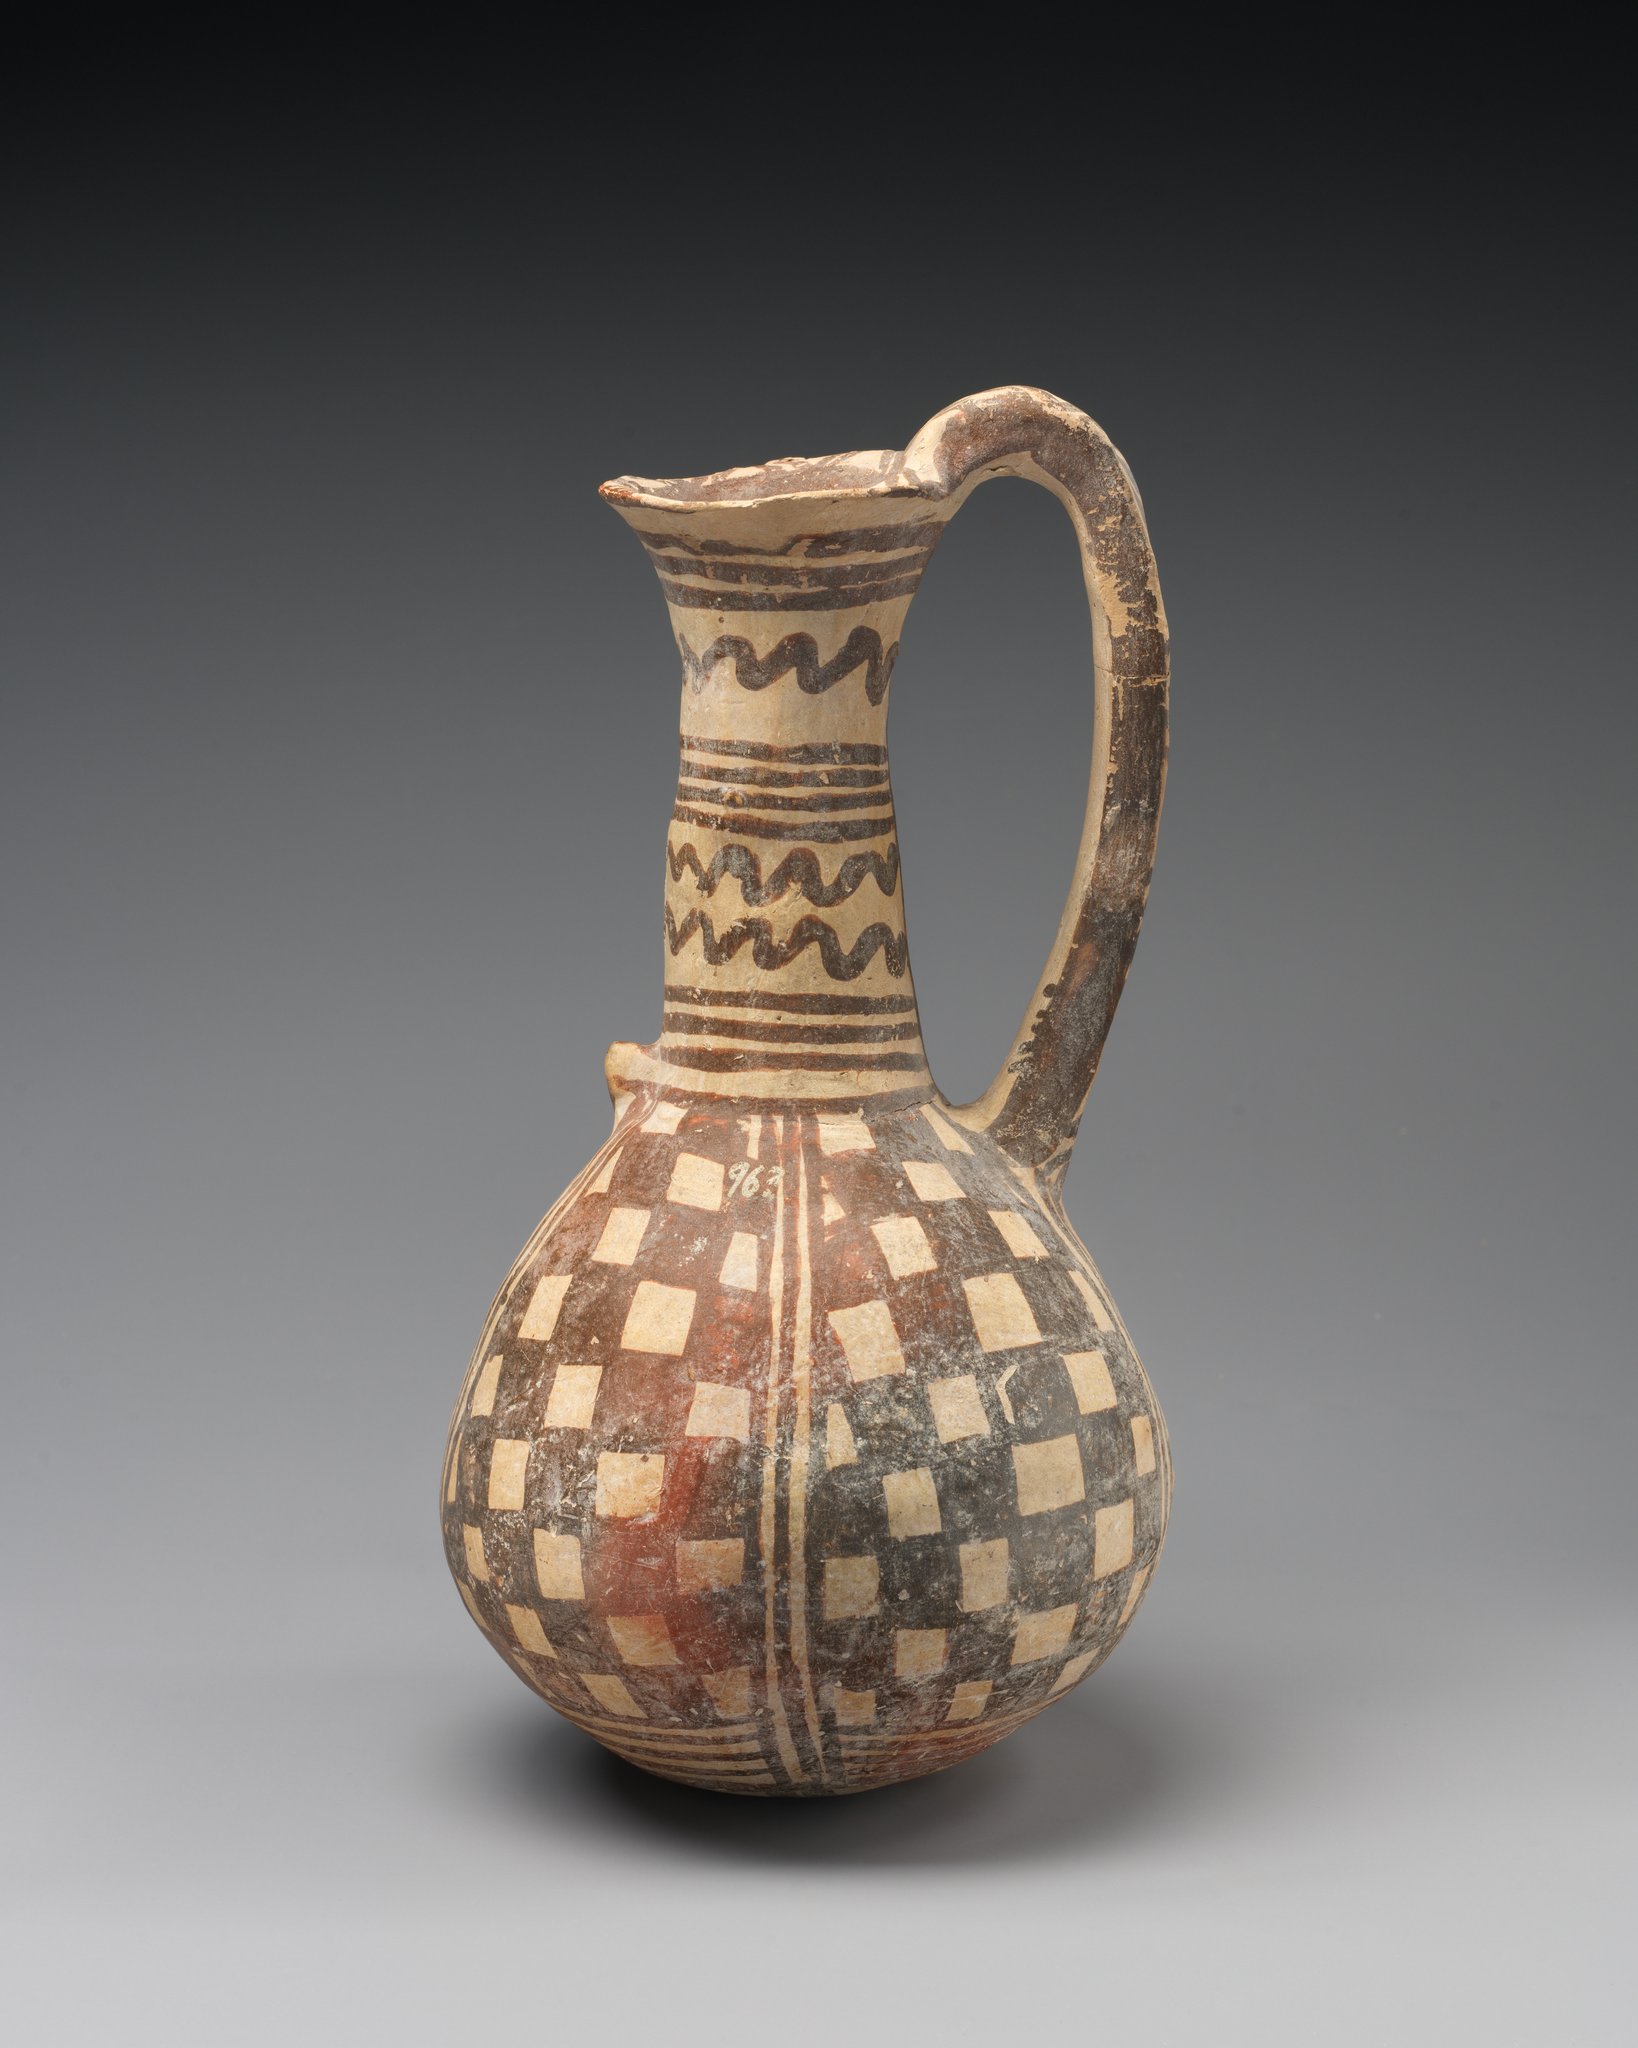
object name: jug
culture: cypriot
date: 1900-1600 BCE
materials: terracotta